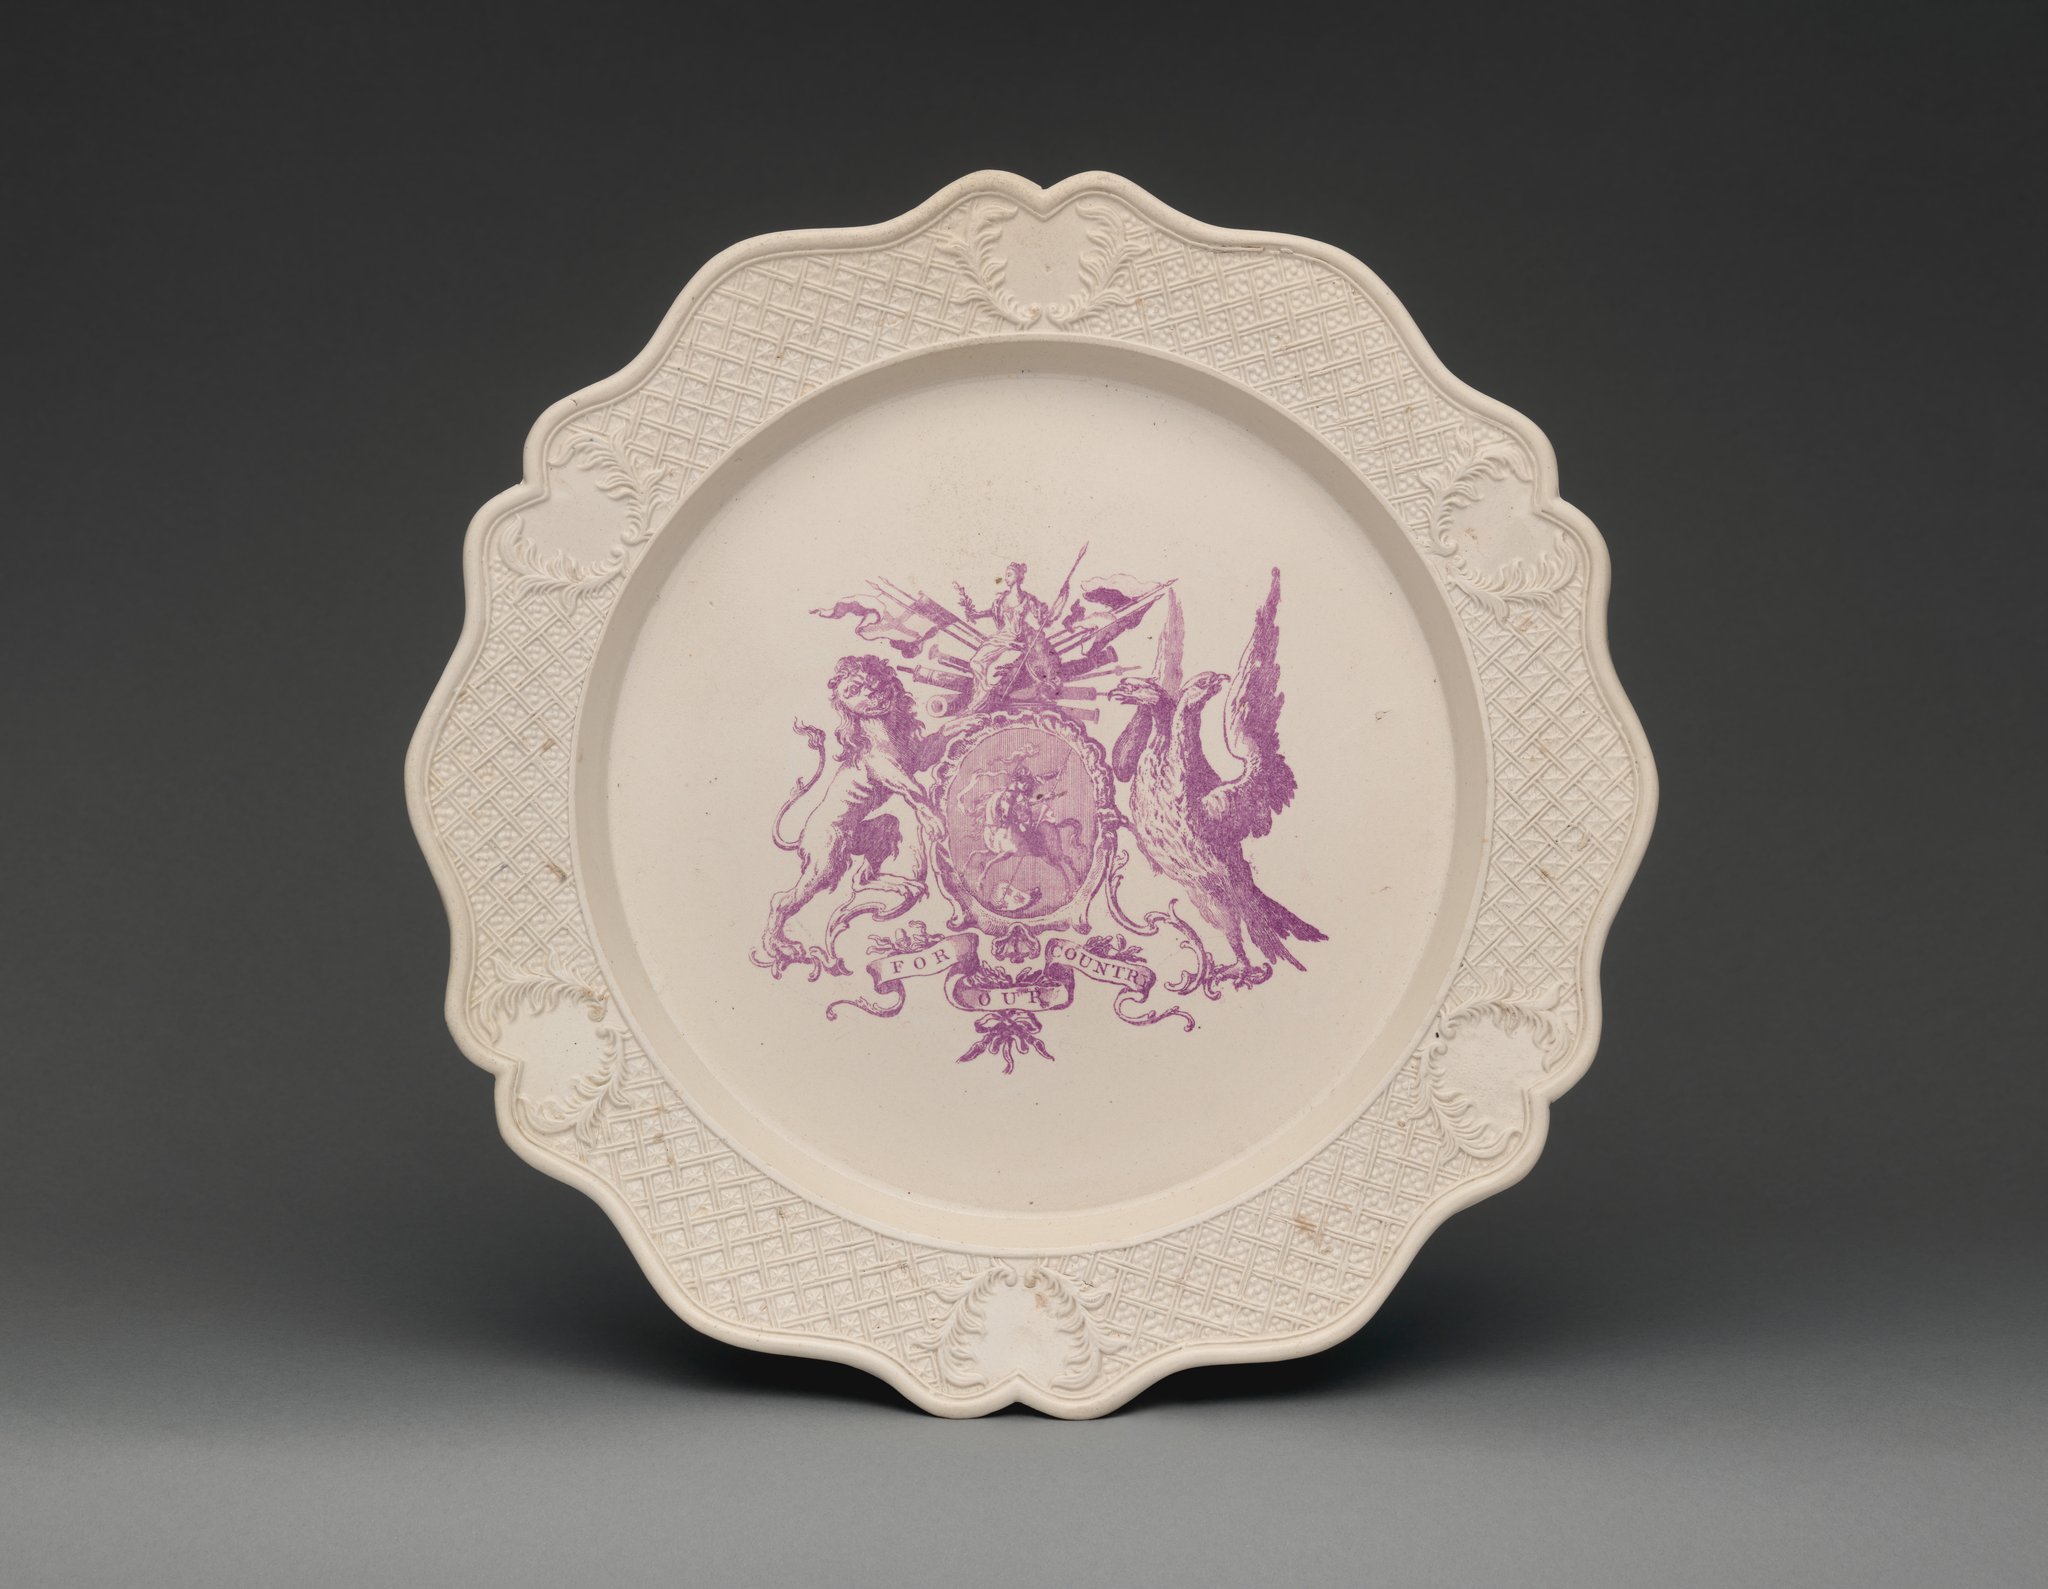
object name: dish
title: Dish with the Arms of the Anti-Gallican Society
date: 1760-1780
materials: stoneware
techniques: salt glaze, transfer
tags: eagles,lions,coat of arms